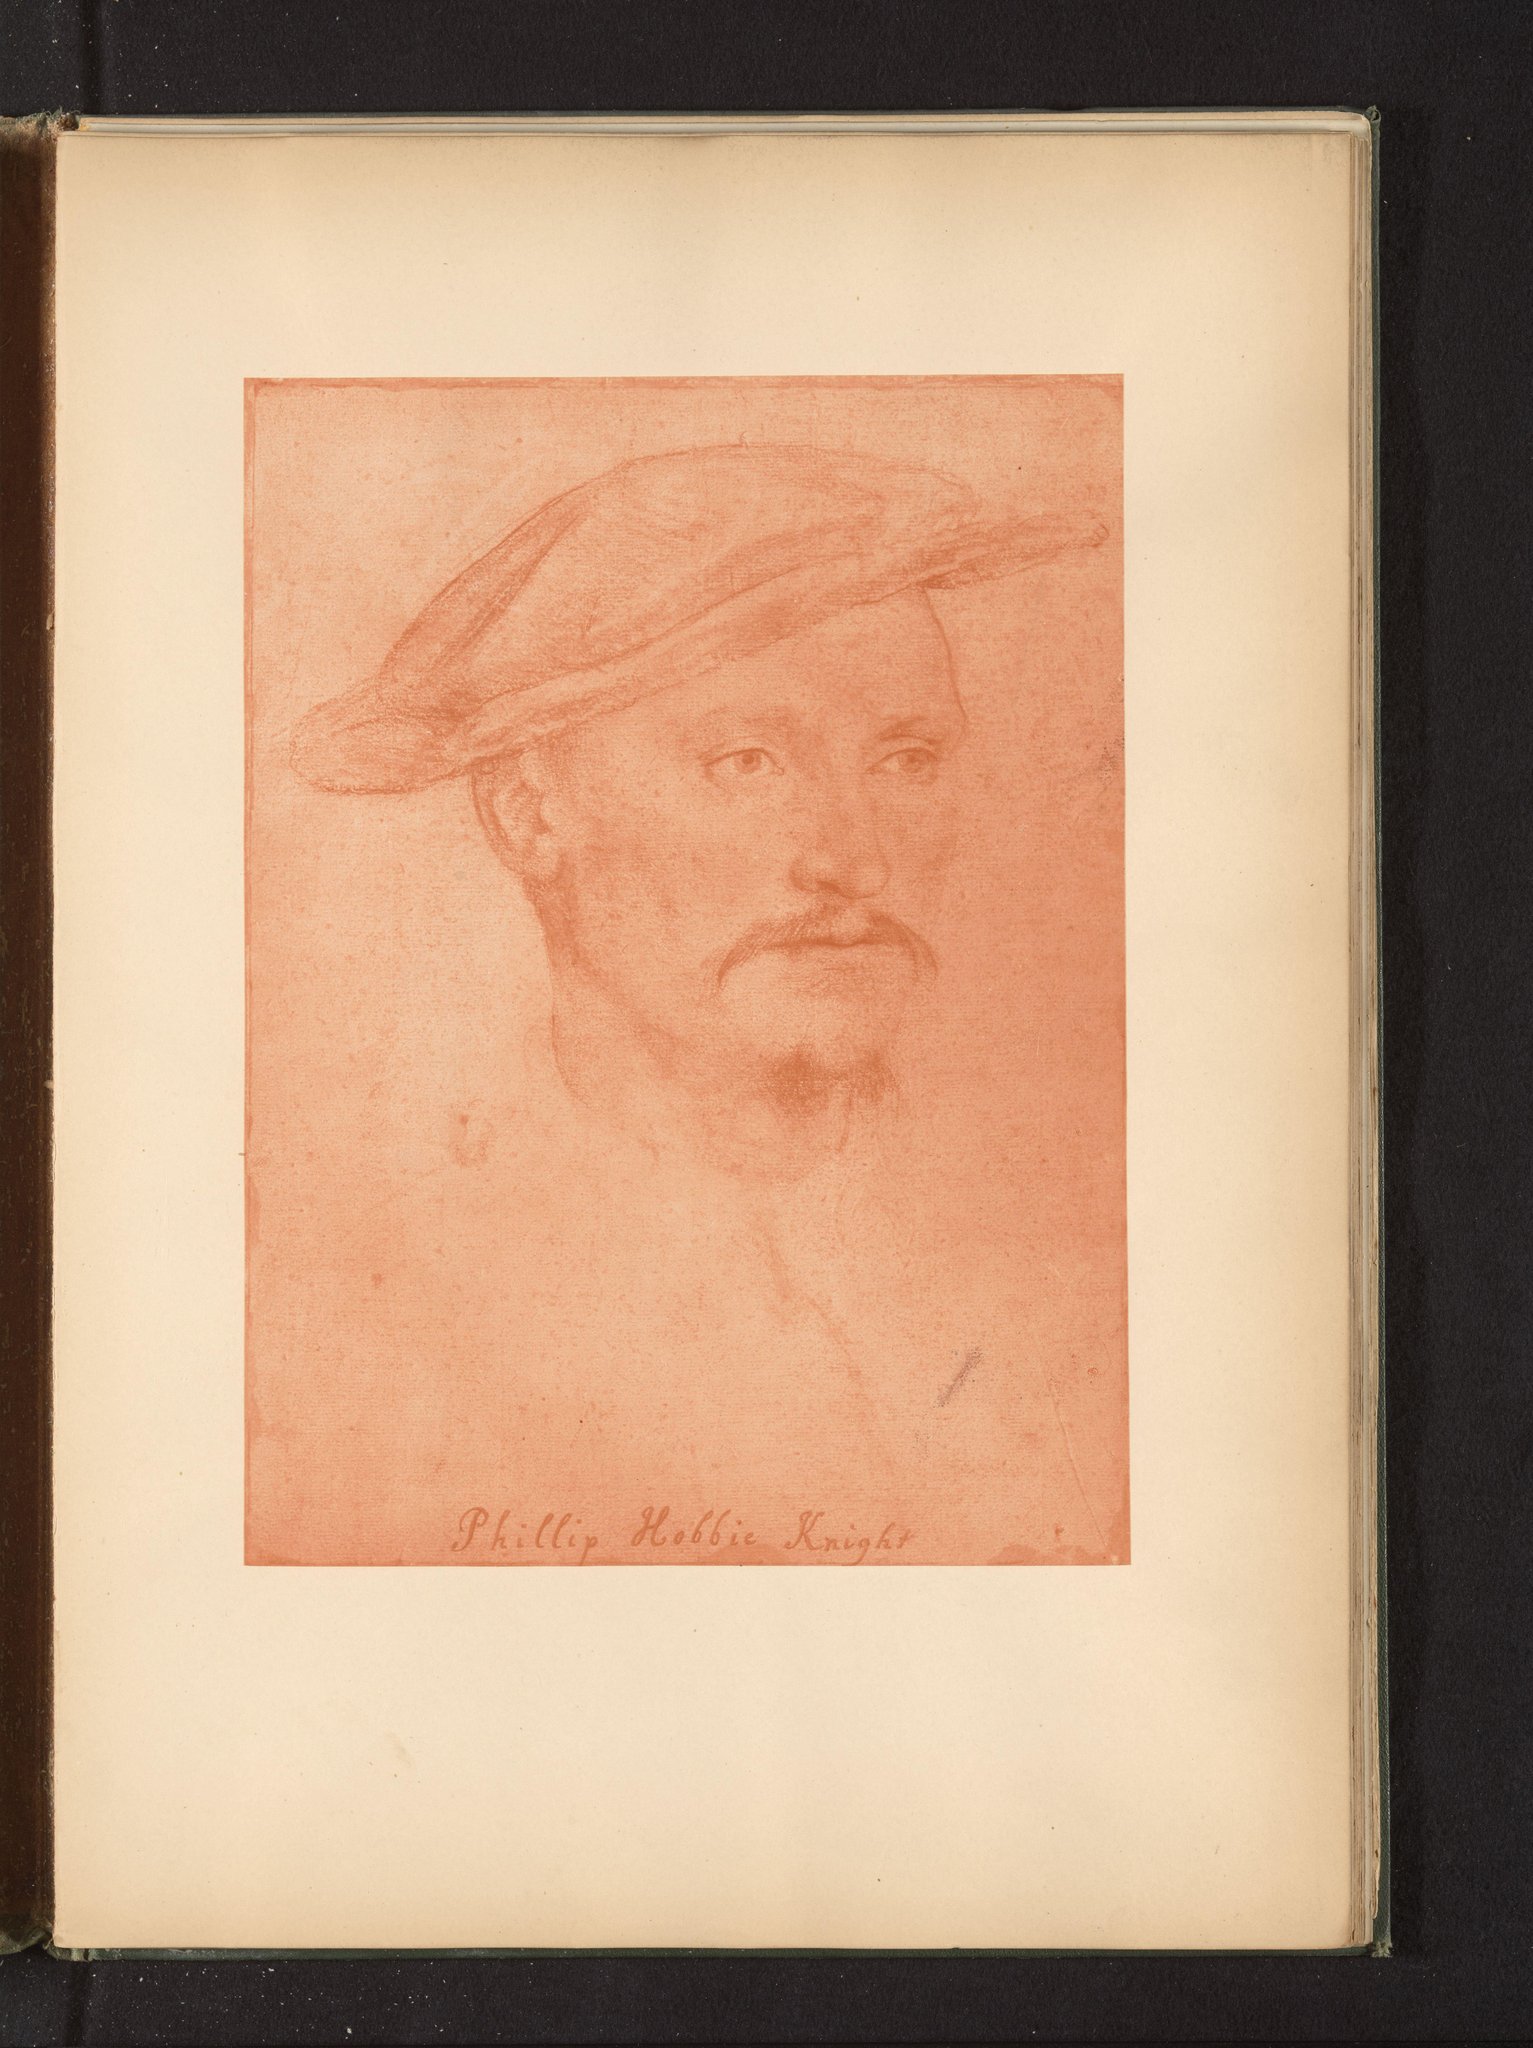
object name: reproduction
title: Fotoreproductie van een portret van Philip Hoby door Hans Holbein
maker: Anonymous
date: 1872-1877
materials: paper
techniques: carbon print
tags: politician, drawing, sketch, historical persons, politician, e.g. party leader